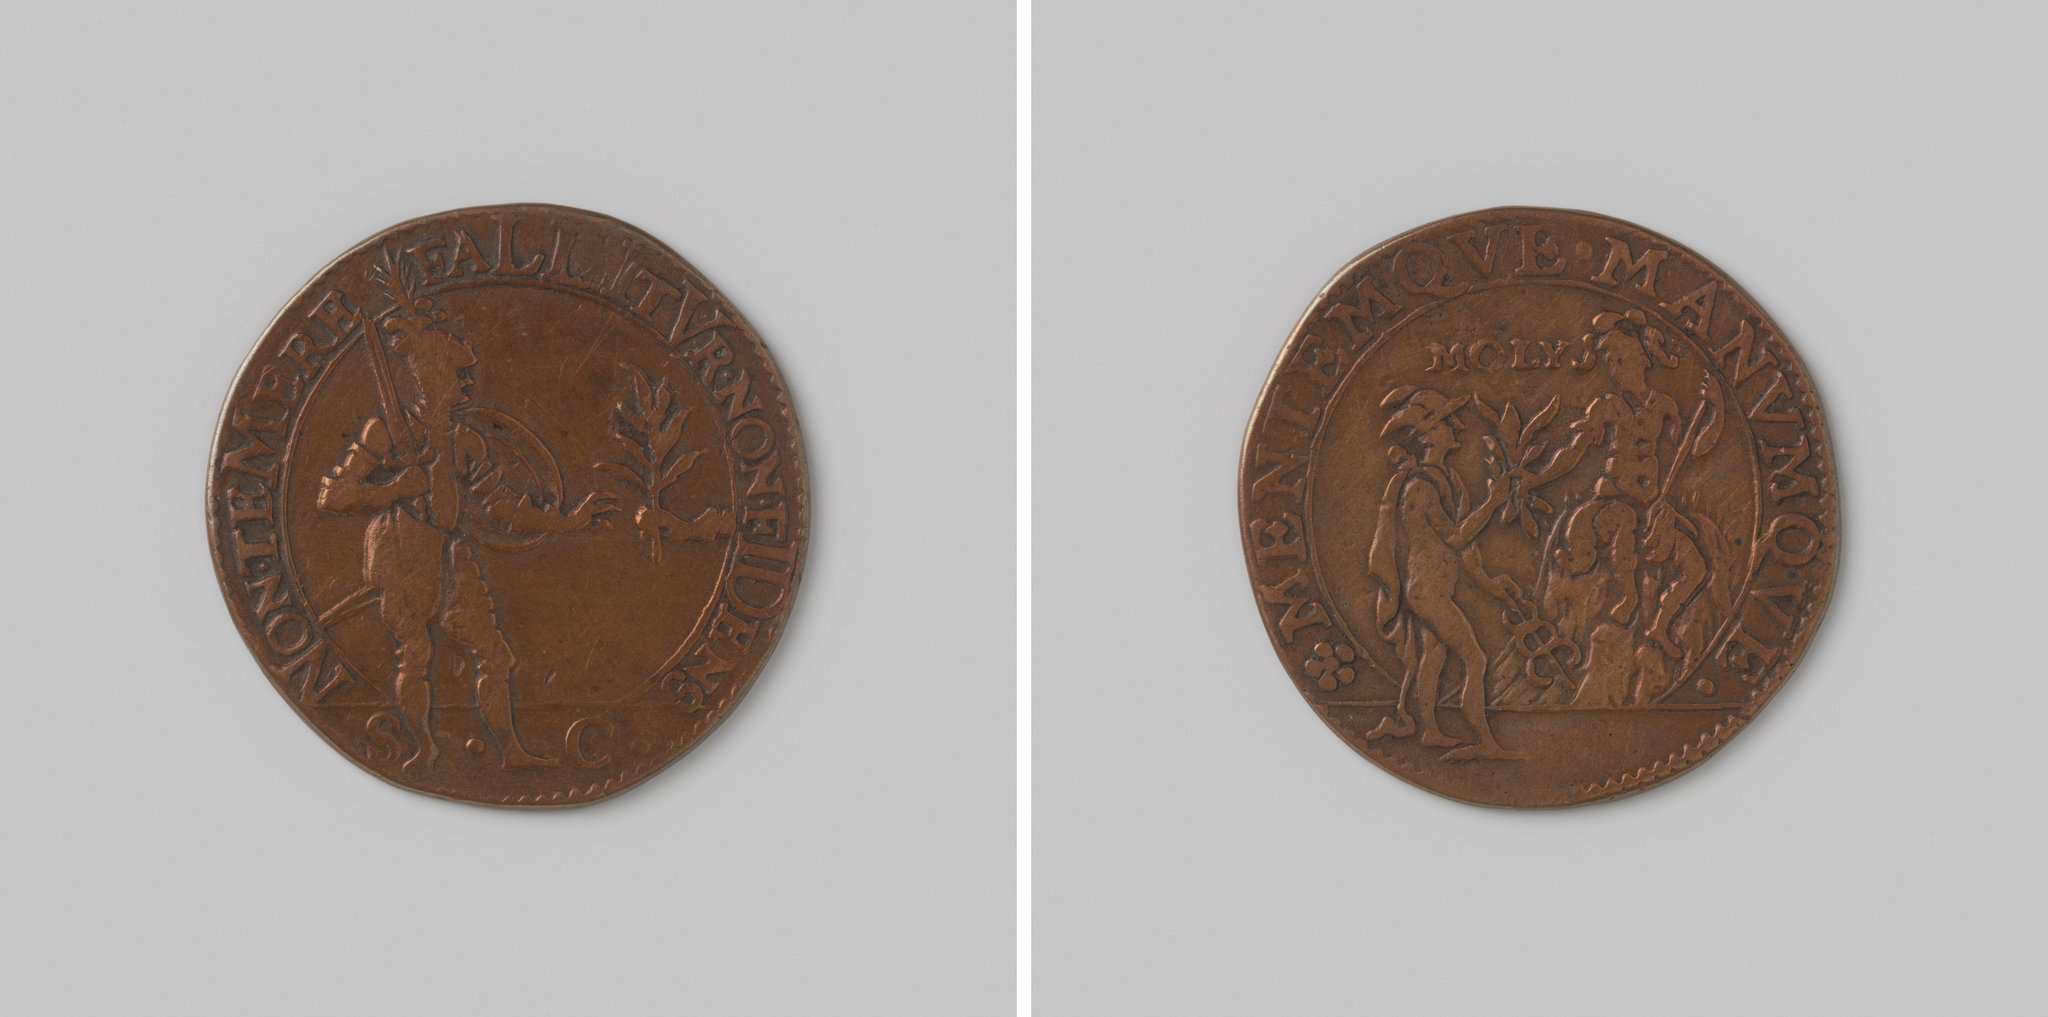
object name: jeton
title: Rekenpenning uit Dordrecht op het heersende wantrouwen tegen een bestand 1607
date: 1607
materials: copper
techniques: striking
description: Koperen penning, op de voorzijde een hand die een soldaat een olijftak aanbiedt, met omschrift, op de keerzijde Mercurius die Odysseus het kruid aanreikt dat beschermt tegen de charmes van Circe, met tekst in het veld en omschrift.